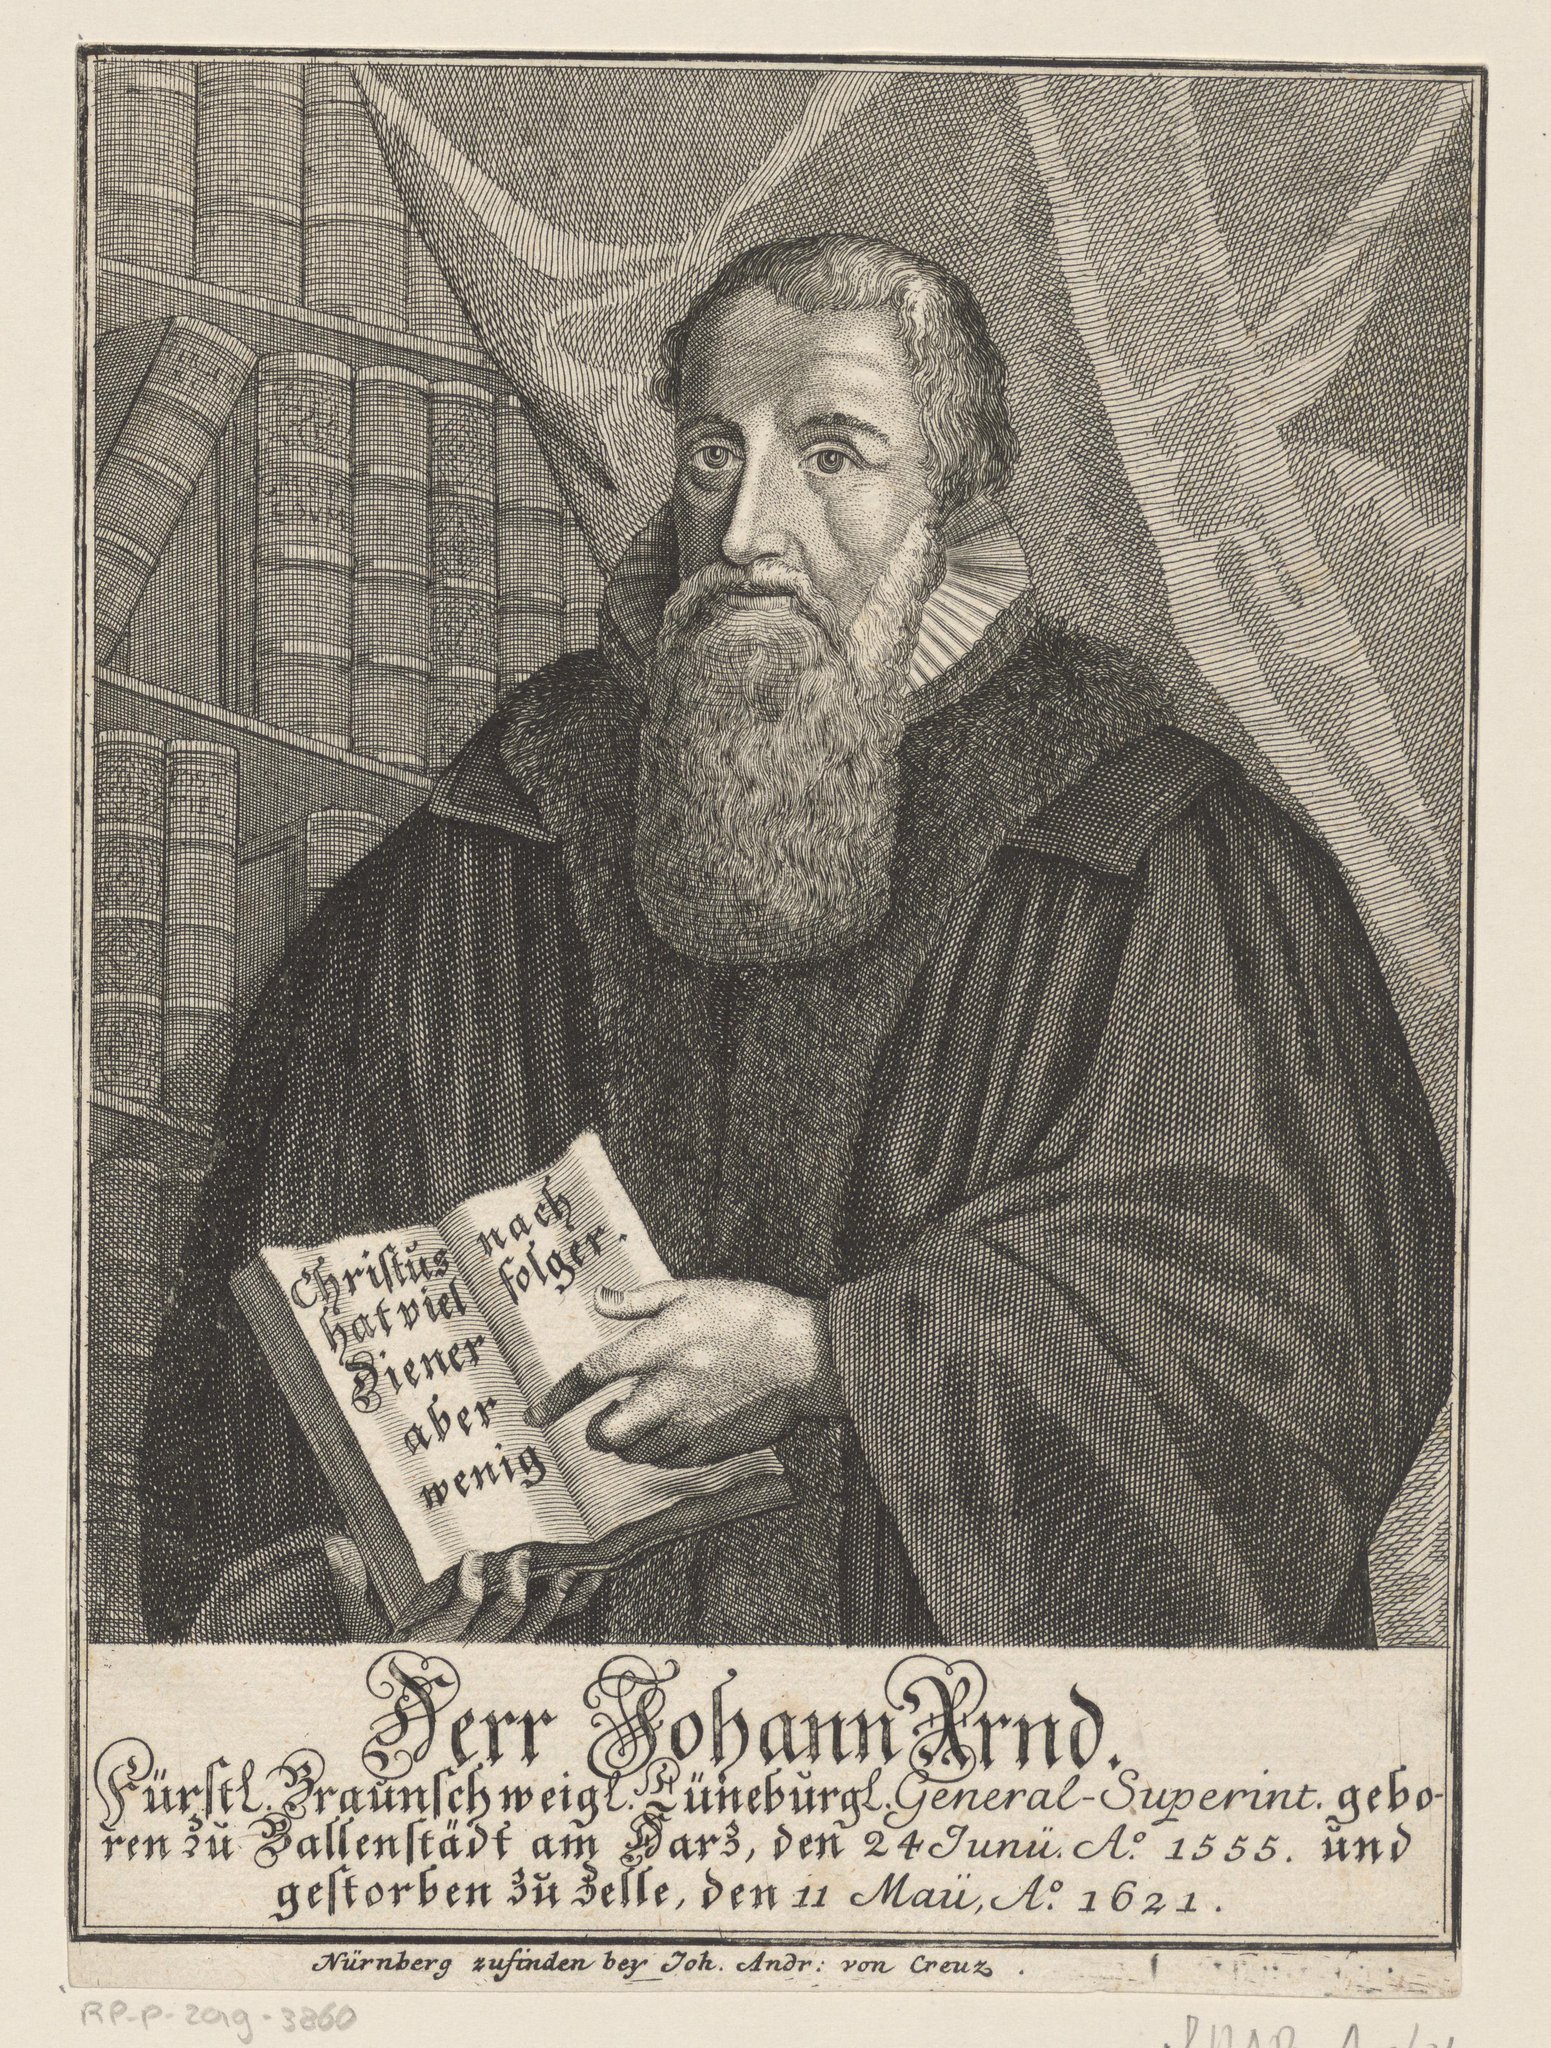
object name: print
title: Portret van Johann Arndt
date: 1730-1744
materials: paper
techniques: engraving, etching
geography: nuremberg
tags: theologian, historical persons, book